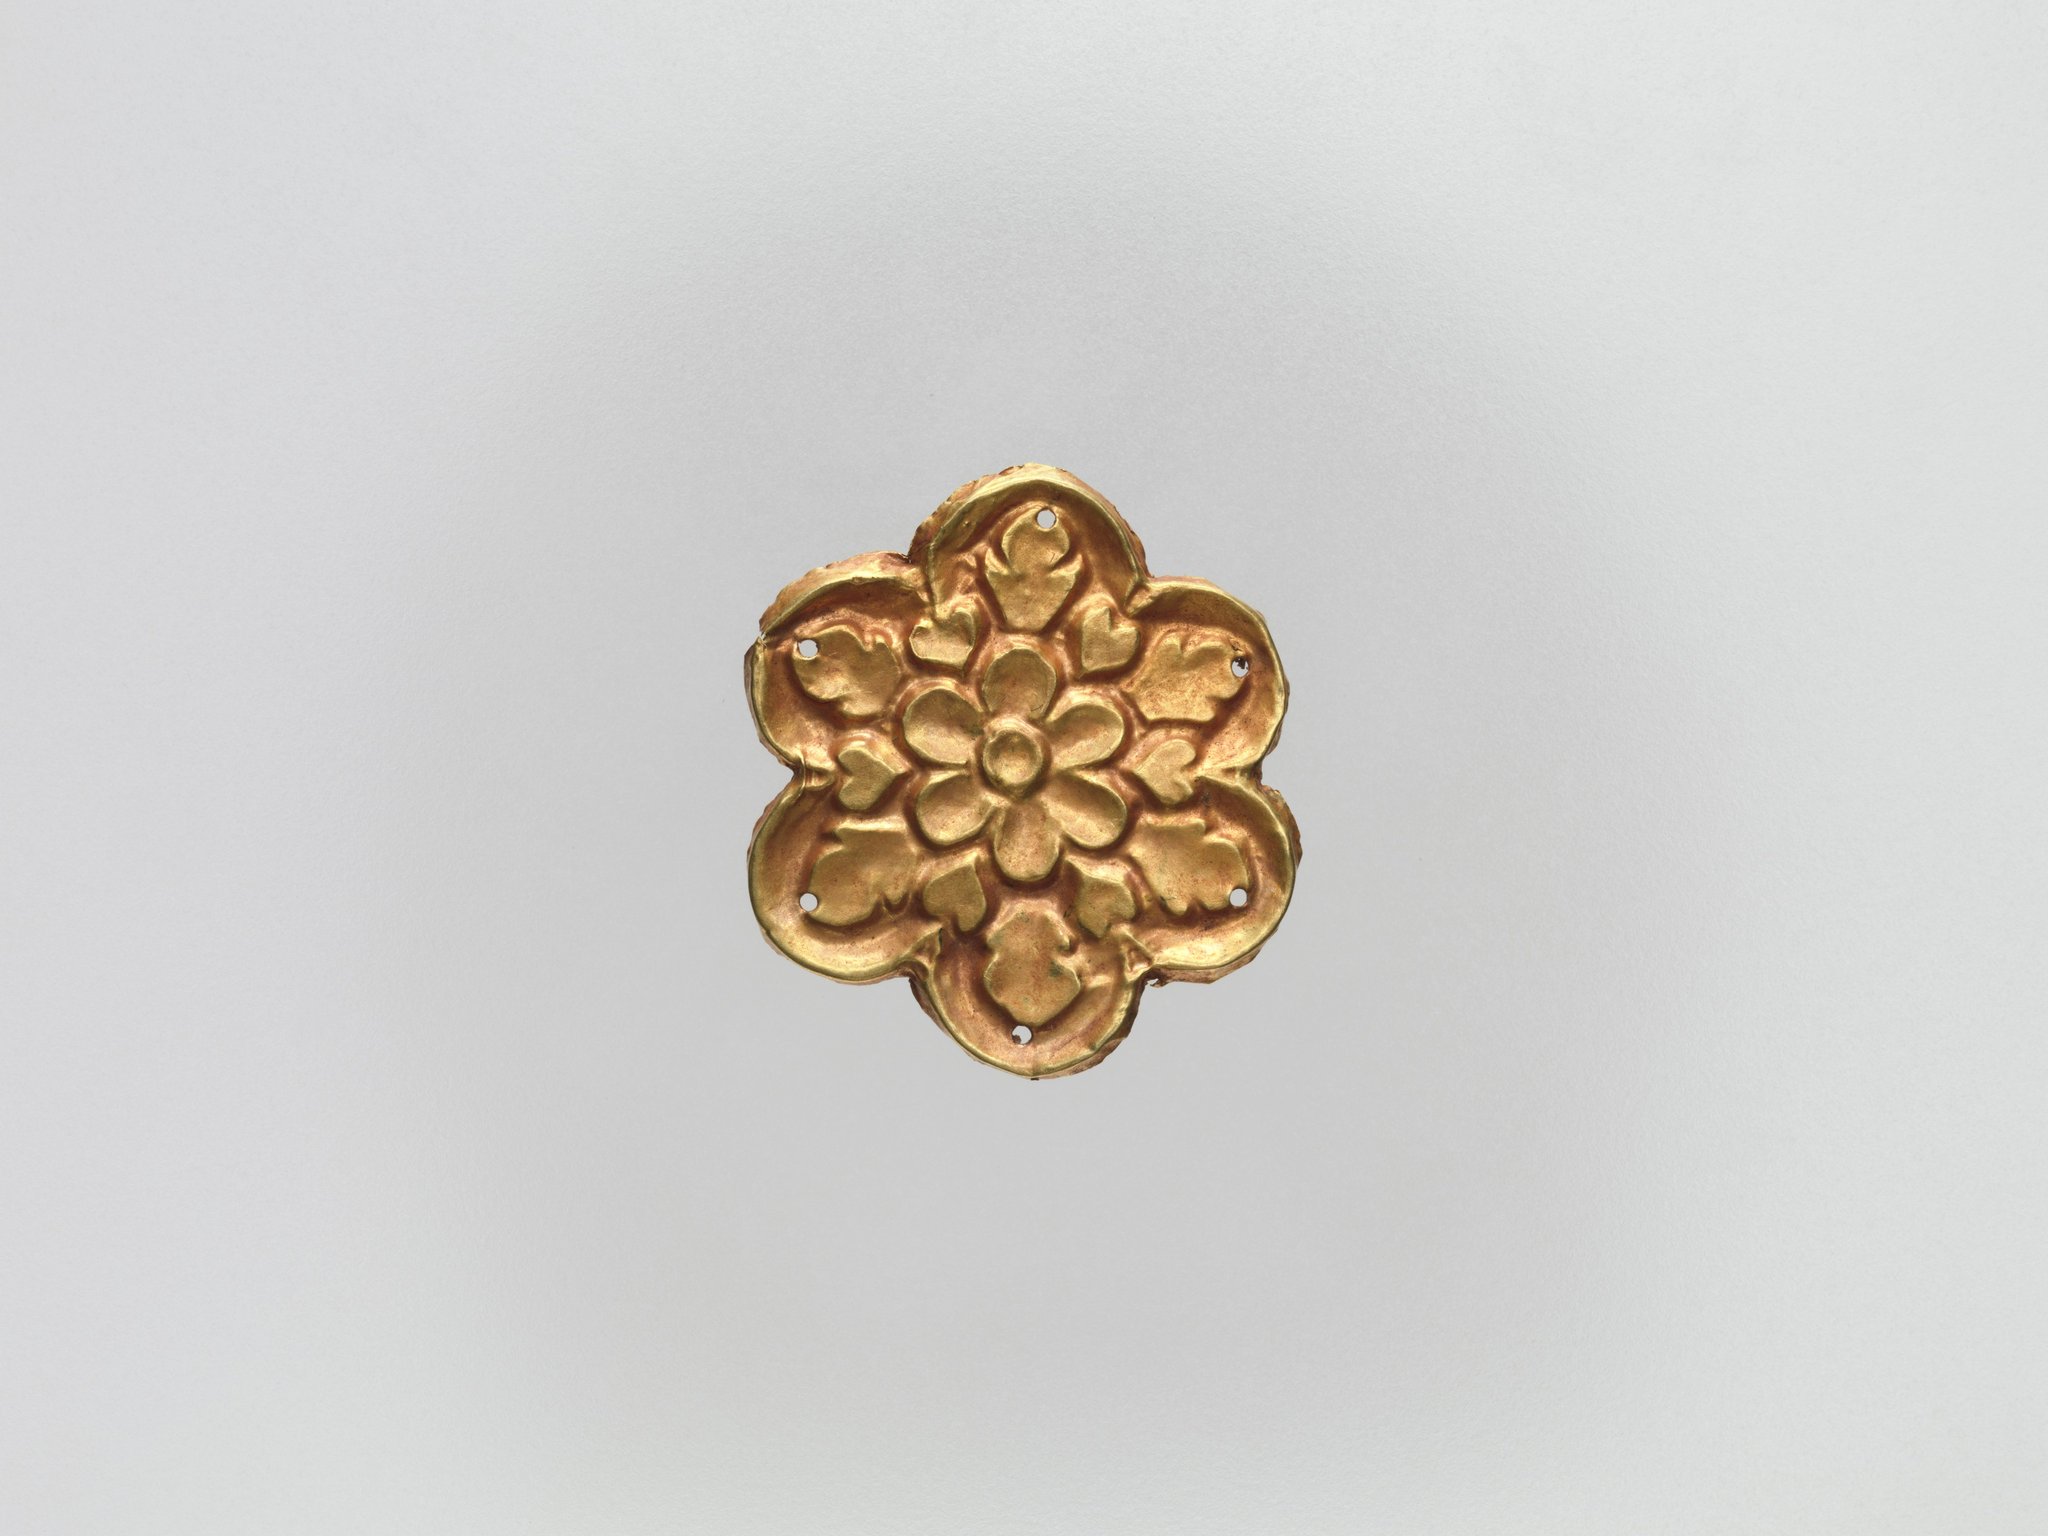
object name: garment plaque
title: Flower-Shaped Clothing Plaque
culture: chinese or central asian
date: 601-900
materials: gold